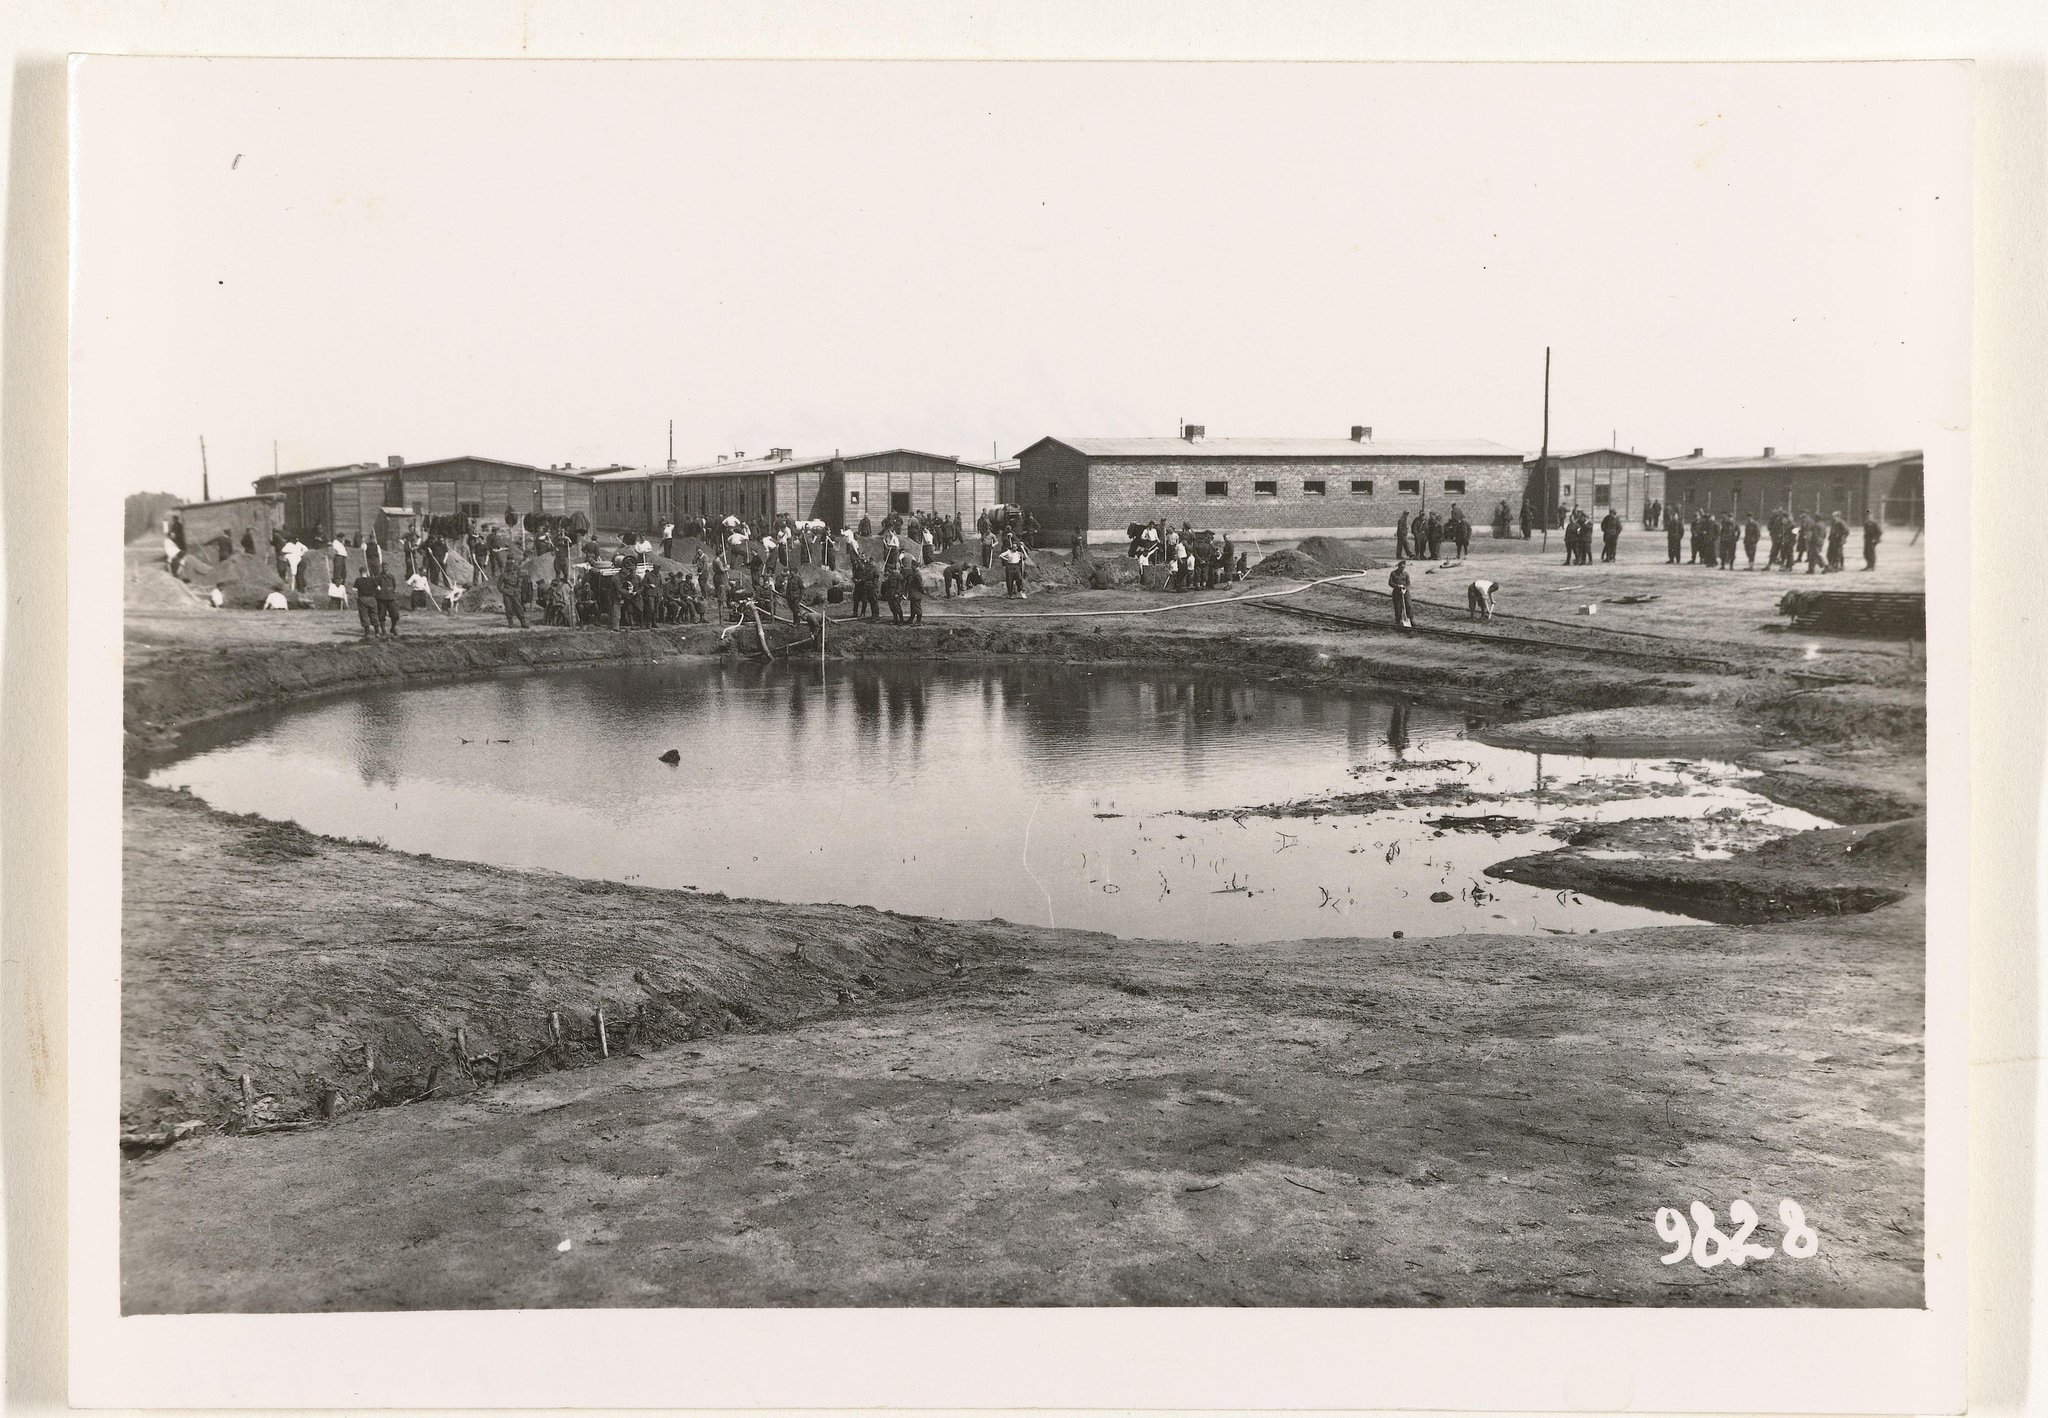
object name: photograph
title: Graven van de vijver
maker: dick w.b. van maarseveen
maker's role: fotograaf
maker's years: 1905-1990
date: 1943-1945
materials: photographic support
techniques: gelatin silver print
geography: muhlberg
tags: dick w.b. van maarseveen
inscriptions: inscription: ‘afgraven zwembad’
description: Het graven van een vijver als waterreservoir voor de brandweer, tevens gebruikt als zwembad voor de recreatie van de gevangenen. Onderdeel van een groep van 130 foto's gemaakt door Dick van Maarseveen in het Duitse krijgsgevangenenkamp Stalag IV B in Mühlberg in de periode 1943-1945.